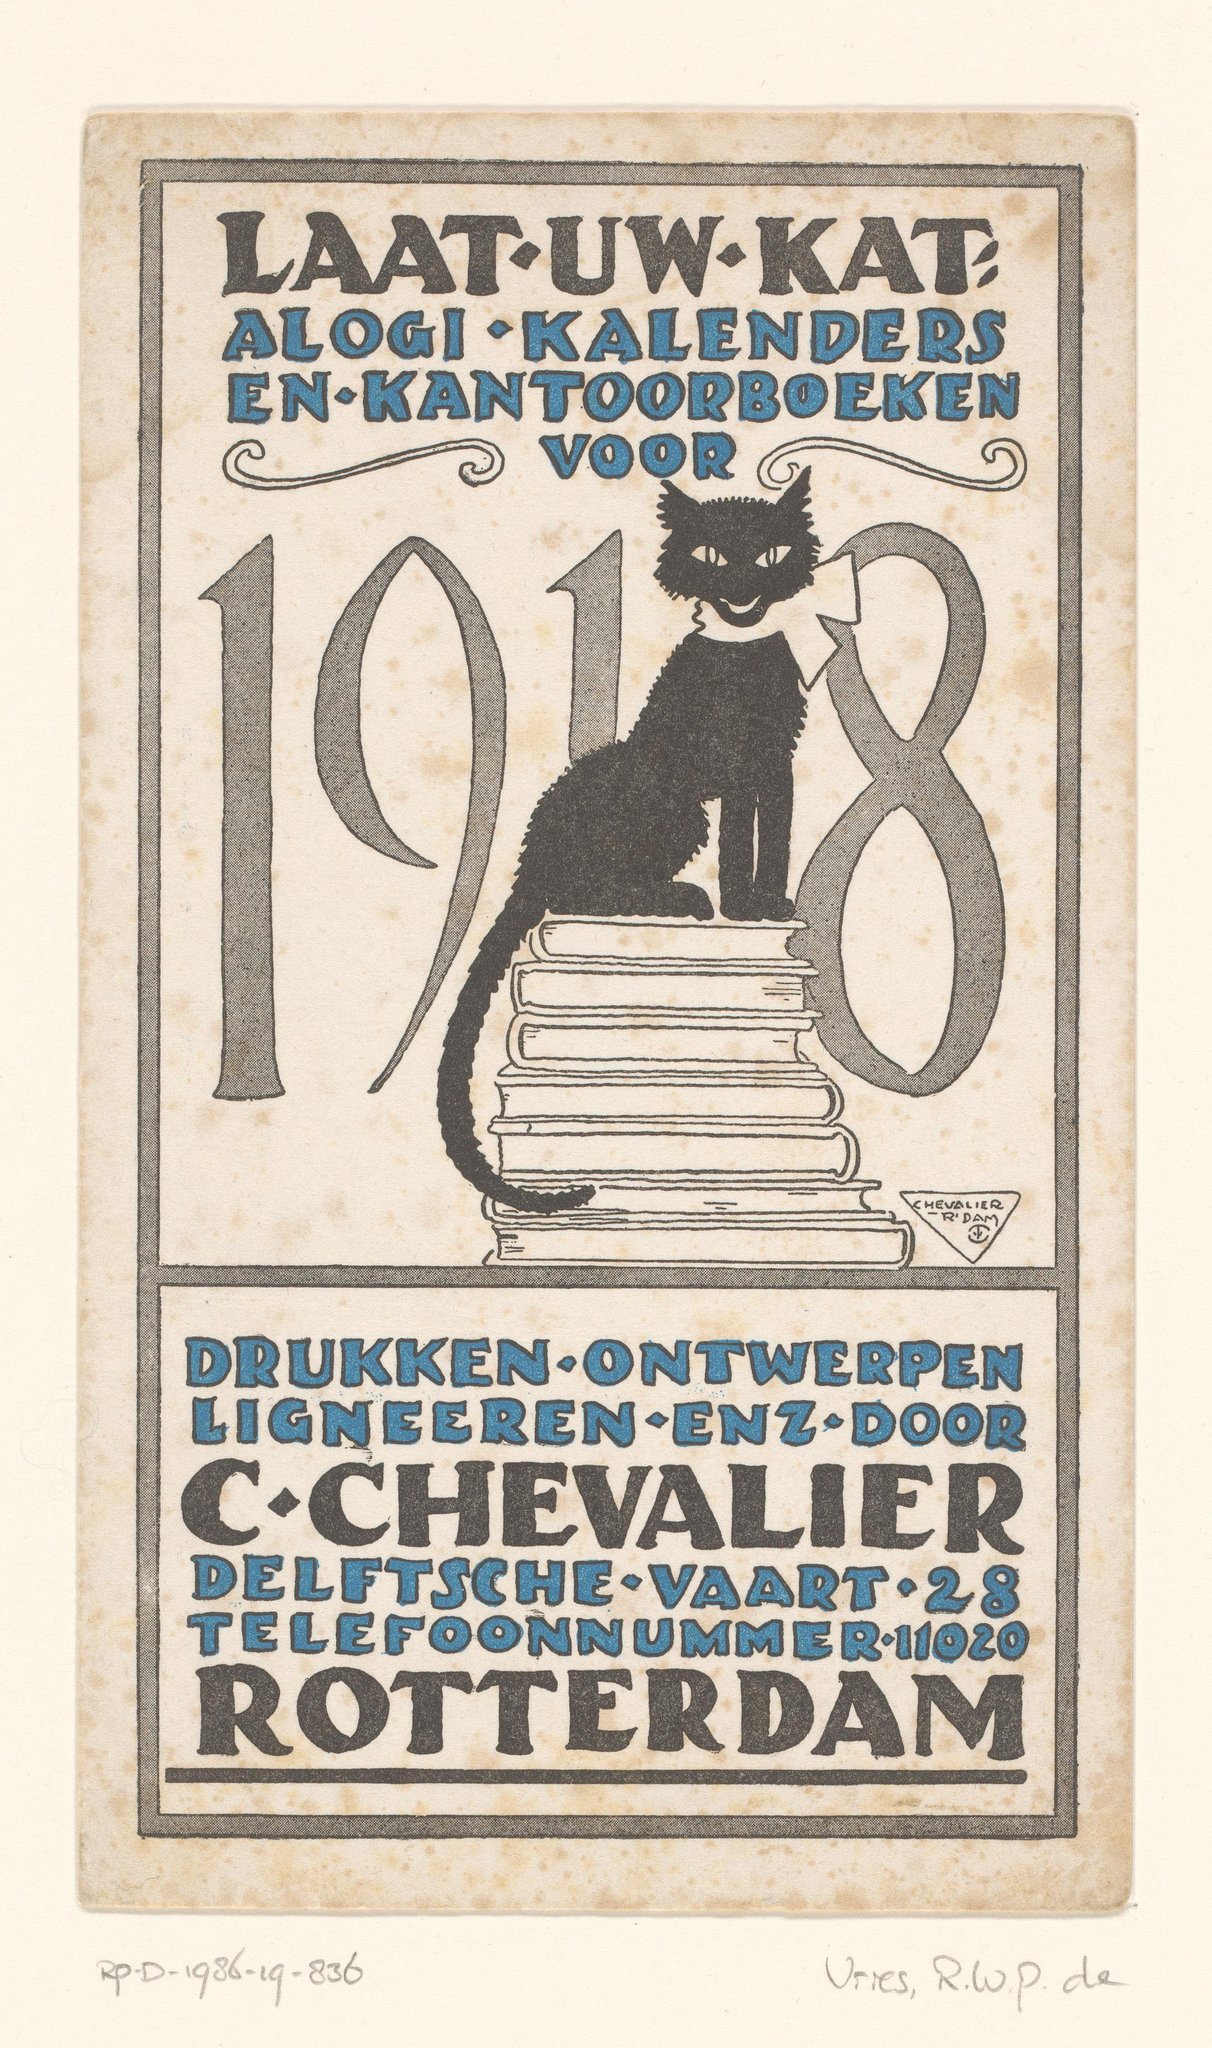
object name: photomechanical print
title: Advertentie van drukkerij C. Chevalier te Rotterdam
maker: cees chevalier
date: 1918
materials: paper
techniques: offset printed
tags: cat, book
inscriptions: date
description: Kat met een strik om de nek zittend op een stapel boeken.